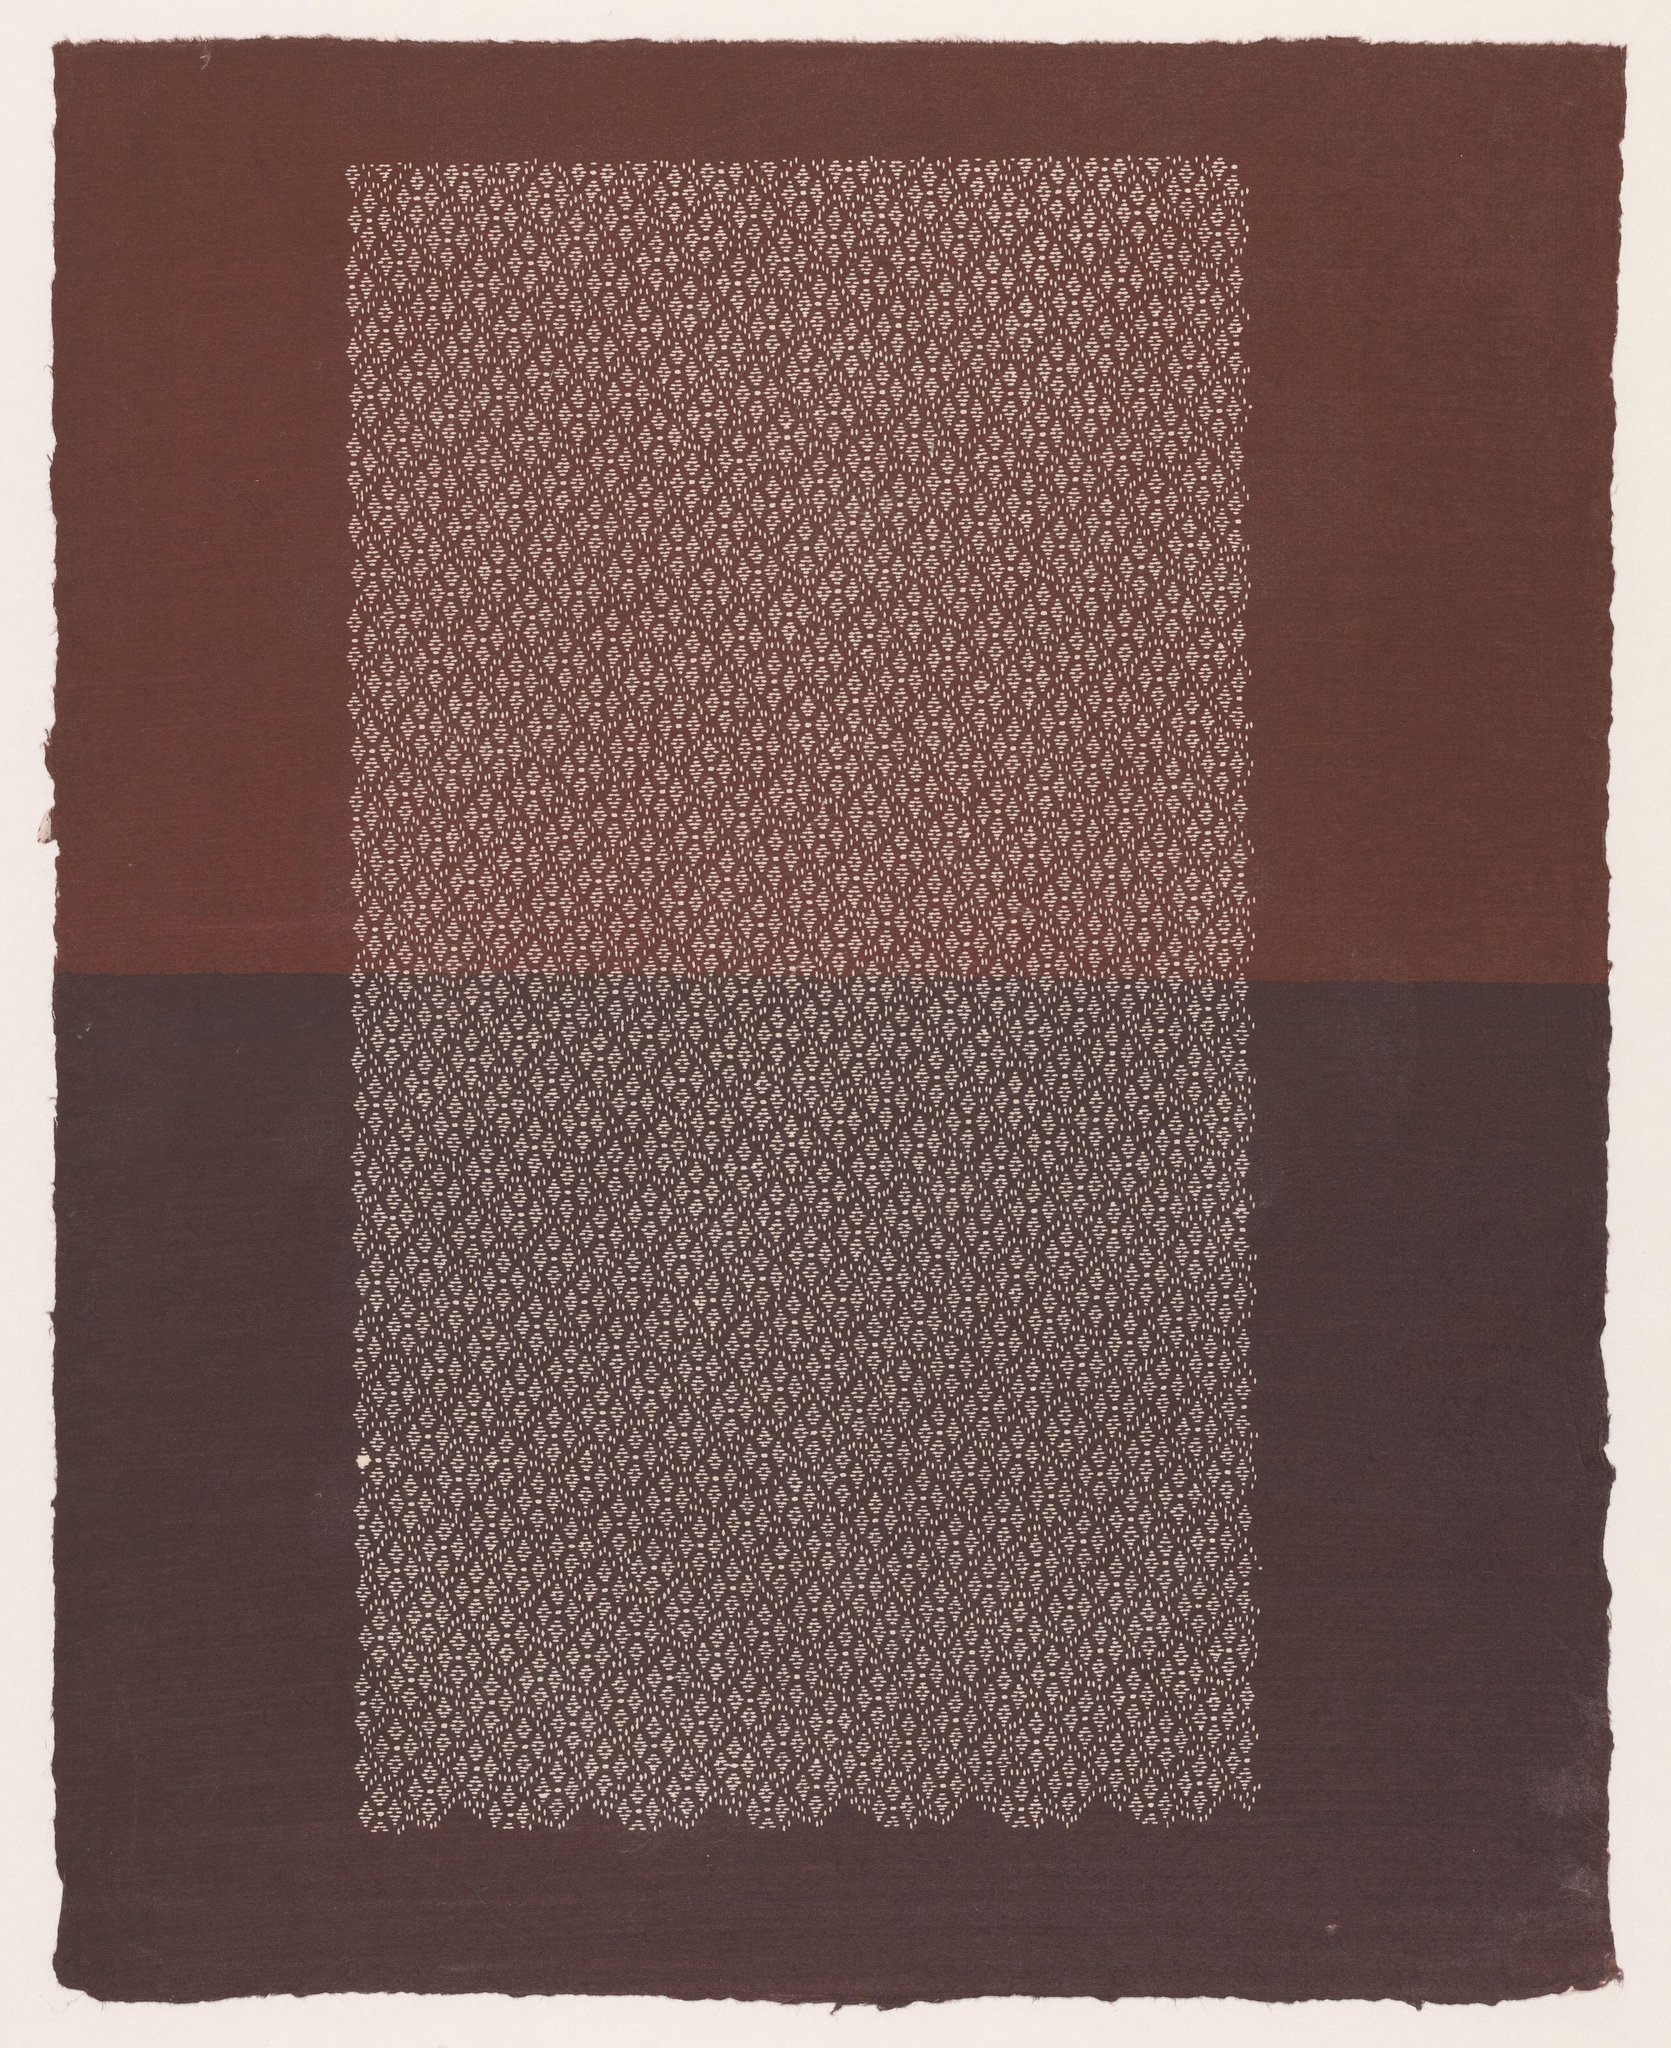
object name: decorated paper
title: Blad met licht- en donkerbruine helften met uitgespaard ruitenmotief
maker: Anonymous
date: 1974-1984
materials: paper, paint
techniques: printing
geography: japan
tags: ornament ~ geometric motifs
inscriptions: collector's mark: Lugt 2760